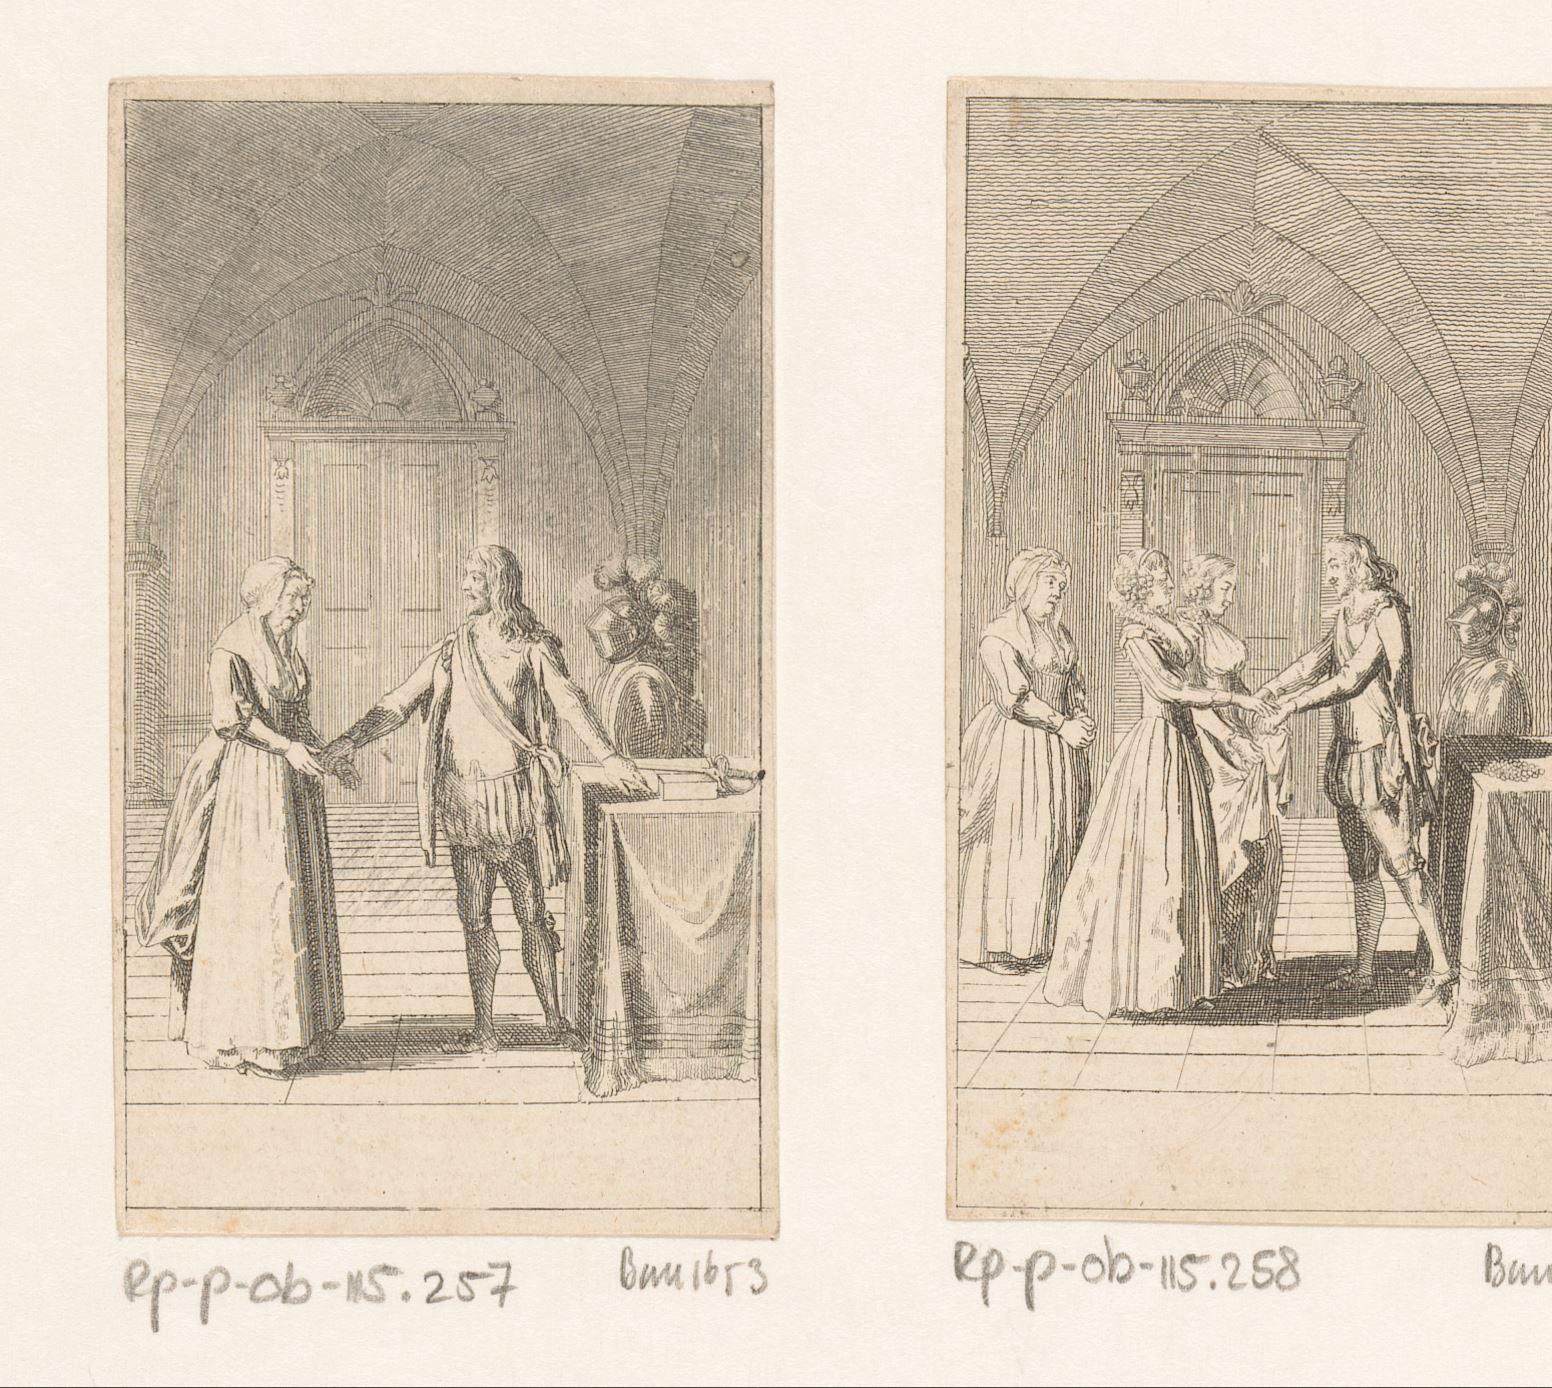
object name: print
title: Pierre Terrail de Bayard bedankt de waardin voor haar goede zorg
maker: daniel nikolaus chodowiecki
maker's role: draughtsman, print maker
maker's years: 1726-1801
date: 1793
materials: paper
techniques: etching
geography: berlin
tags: pierre du terrail de bayard, history, departure ~ travelling, knight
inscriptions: collector's mark: Lugt 2228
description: Vervaardigd als één van twaalf voorstellingen uit de oudste, middelste en nieuwste geschiedenis. Latere staat gebruikt voor: Genealogischen Calender zur angenehmen und nützlichen Unterhaltung auf das Jahr 1794. Berlijn: Königl. Akademie der Wissenschaften, [1793].